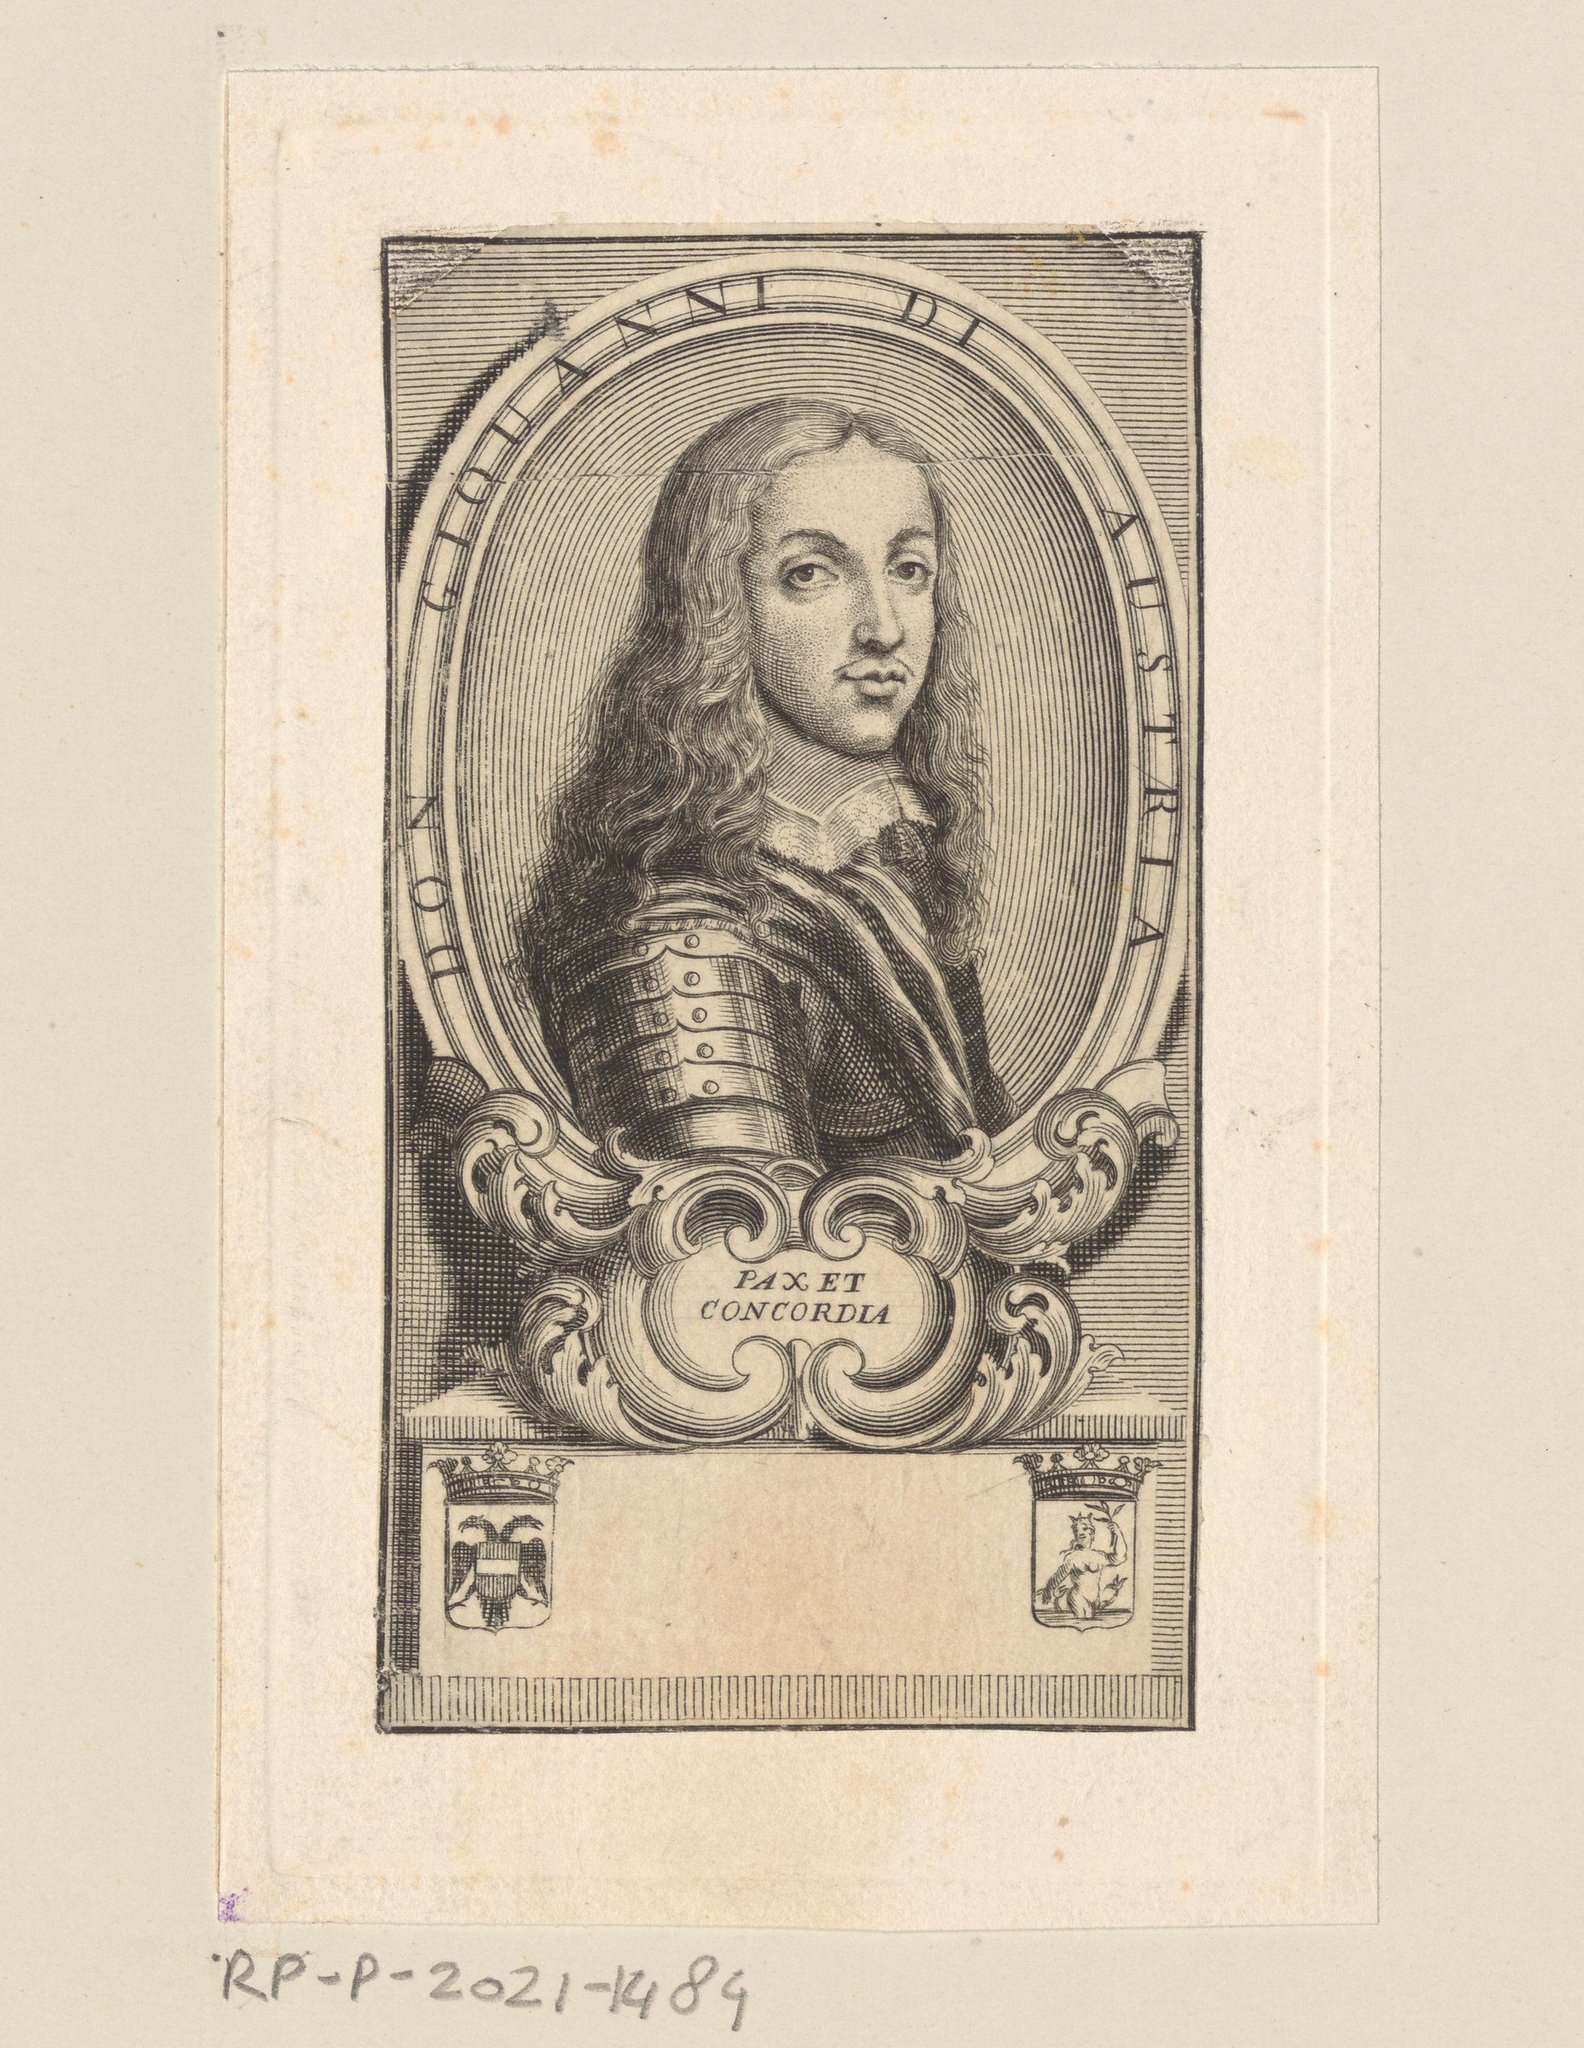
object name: print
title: Portret van Don Juan II van Oostenrijk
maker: Anonymous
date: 1642-1699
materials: paper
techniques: engraving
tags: historical persons, ruler, sovereign, armorial bearing, heraldry